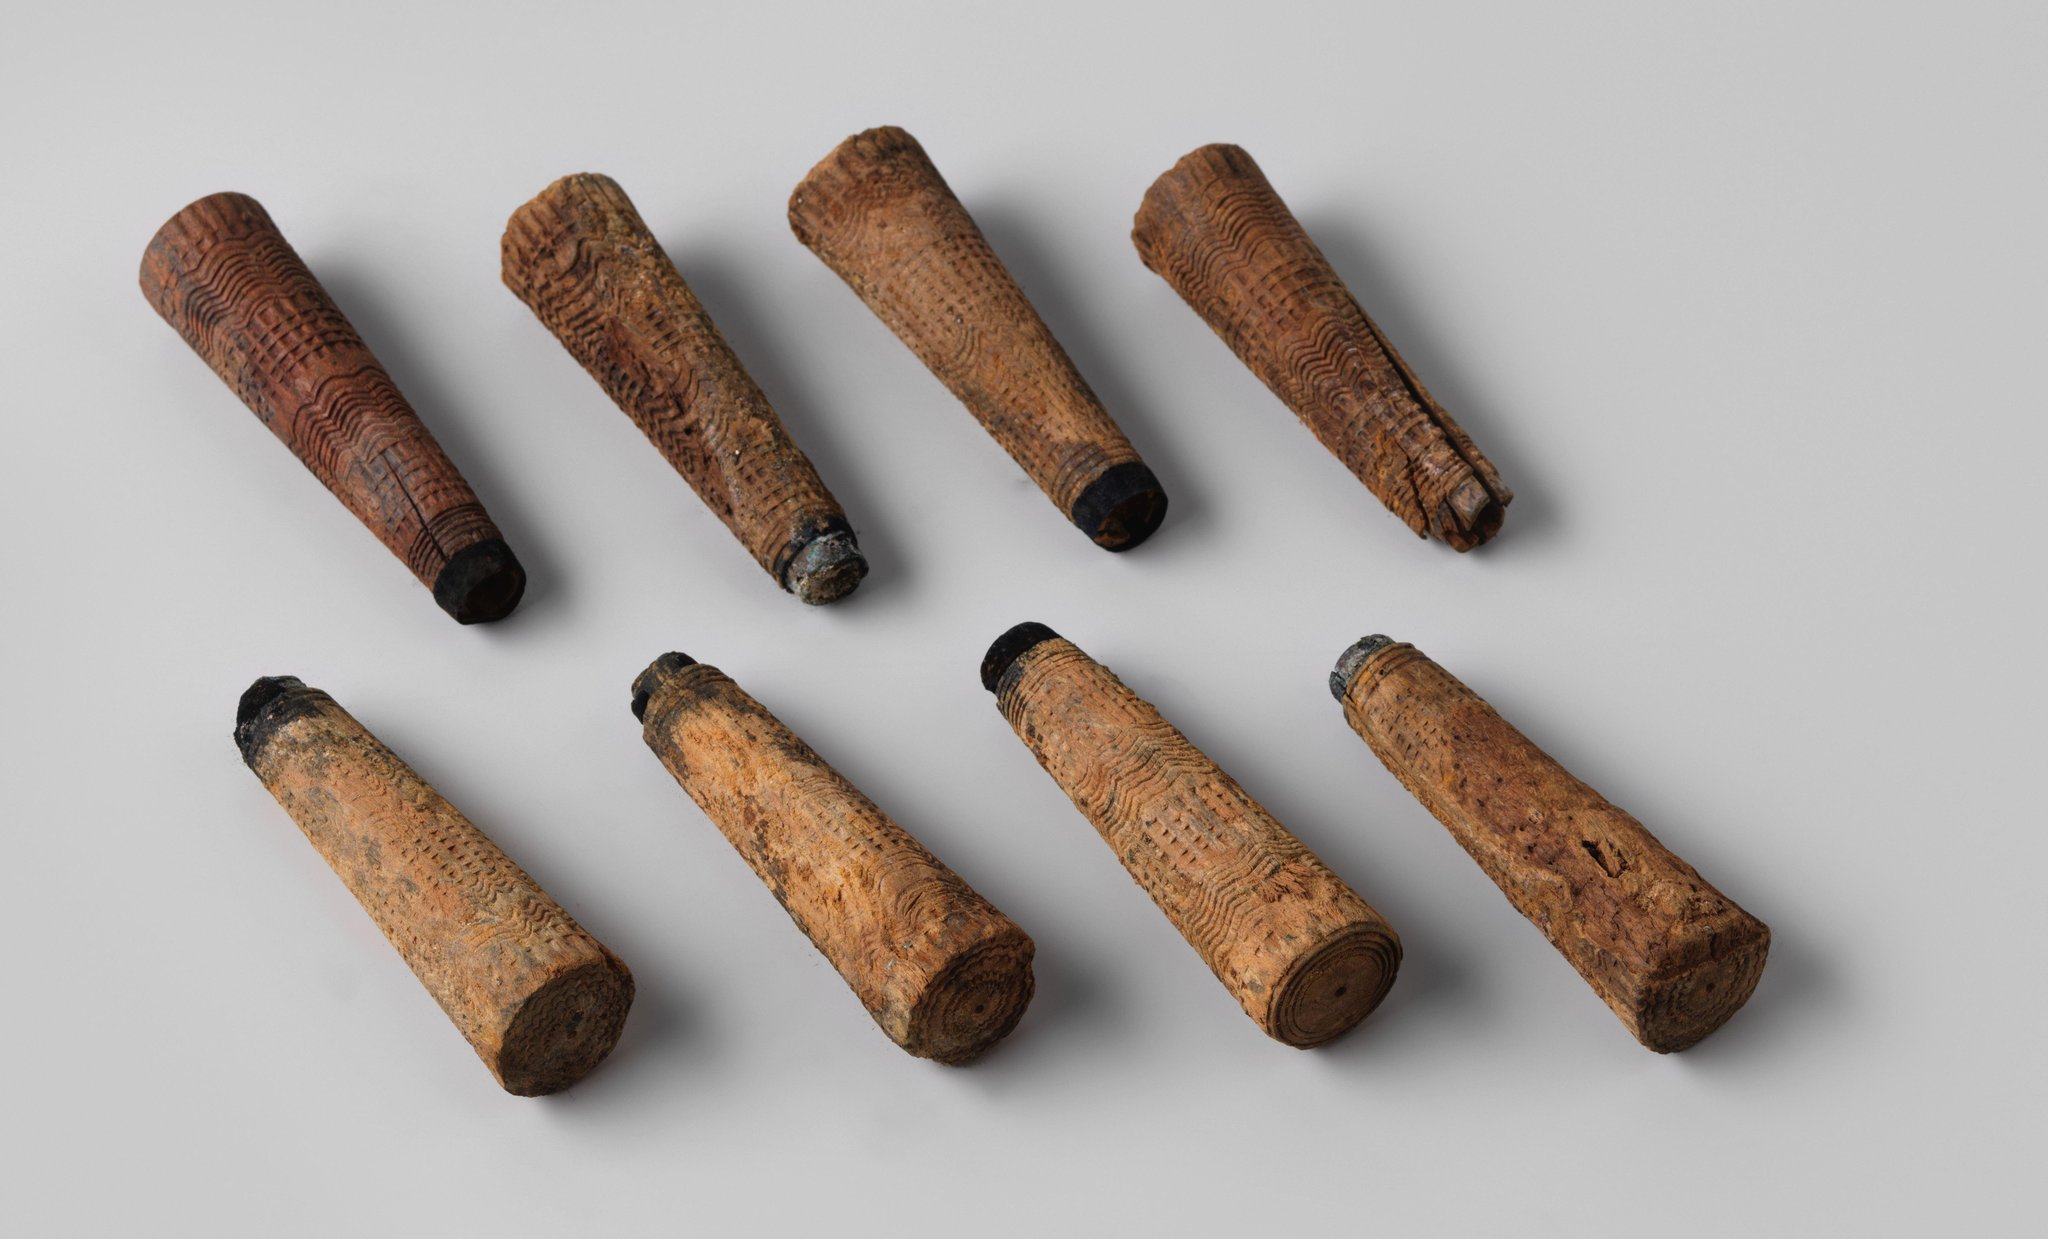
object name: knife handle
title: Messenheften en losse koperringen uit het wrak van de Oost-Indiëvaarder Hollandia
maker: Anonymous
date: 1700-1743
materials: copper, wood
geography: netherlands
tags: verenigde oostindische compagnie, hollandia (schip), annet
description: Knife, handle, cylindrical: tapering; id. NG 1979-403H, ferrules, id. NG 1980-27H426.